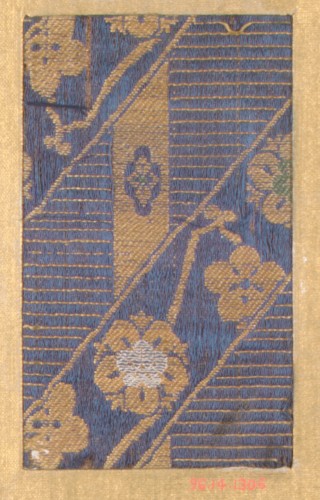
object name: piece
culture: japanese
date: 1701-1900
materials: silk